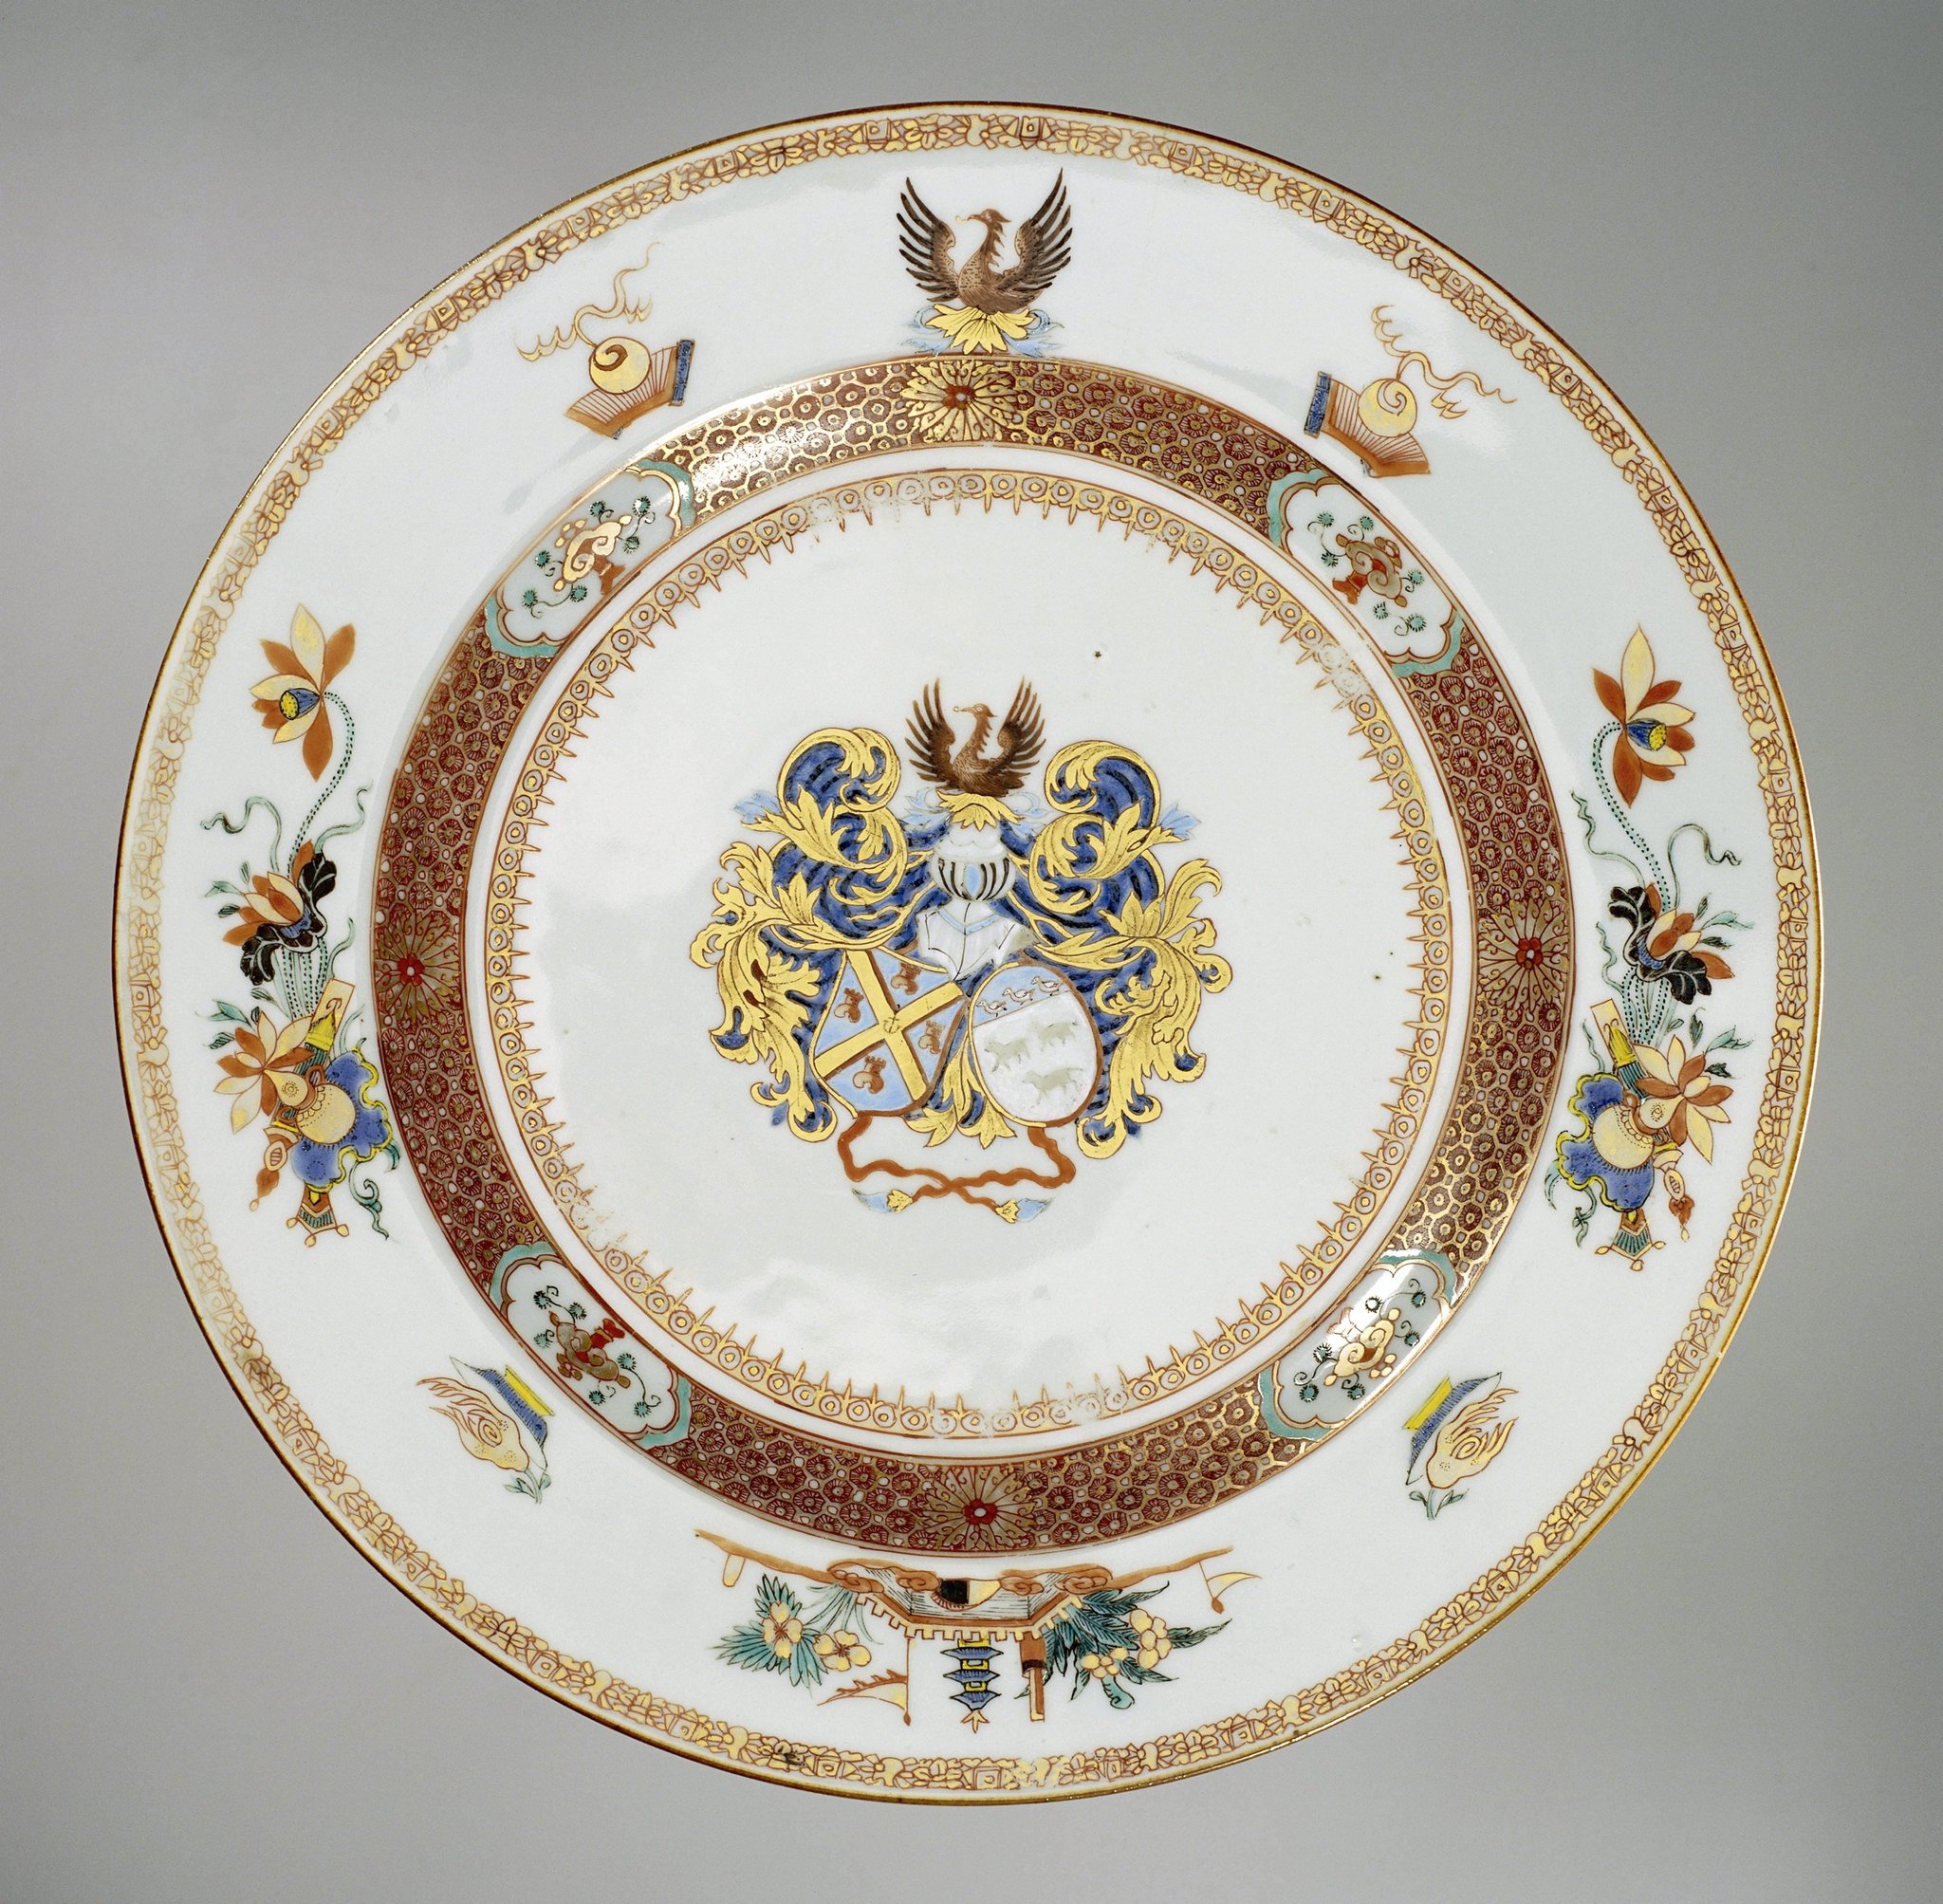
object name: platter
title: Dish with the arms of the De Neufville and De Wolff families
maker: Anonymous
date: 1720-1730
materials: glaze, gold, paint, porcelain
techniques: firing, gilding, turning, vitrification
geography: china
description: Schotel van porselein, beschilderd op het glazuur in blauw, rood, groen, geel, zwart en goud. Op het plat het alliantiewapen van de familie De Neufville en De Wolff. Het wapen links is van de familie De Neufville en bestaat uit vier torens en een gouden sint-andrieskruis met in het midden een anker. Het wapen rechts is van de familie De Wolff en bestaat uit wolven en gierzwaluwen. Het helmteken is een vogel. De wapens worden omgeven door een dekkleed van blauwe en gouden bladranken en onderaan twee kwastjes. Om het wapen een spearhead-border. Op de wand een band met honingraatpatroon afgewisseld met vier keer een gestileerde lotus en een gelobd catouche met ruyi-motief. Op de rand twee lotusranken, het helmteken, een paviljoen en gelukssymbolen (parel, vingercitroen); hieromheen een decoratieve band. De achterzijde met vier bloemtakken. Een barst in de rand. Wapenporselein met emailkleuren.